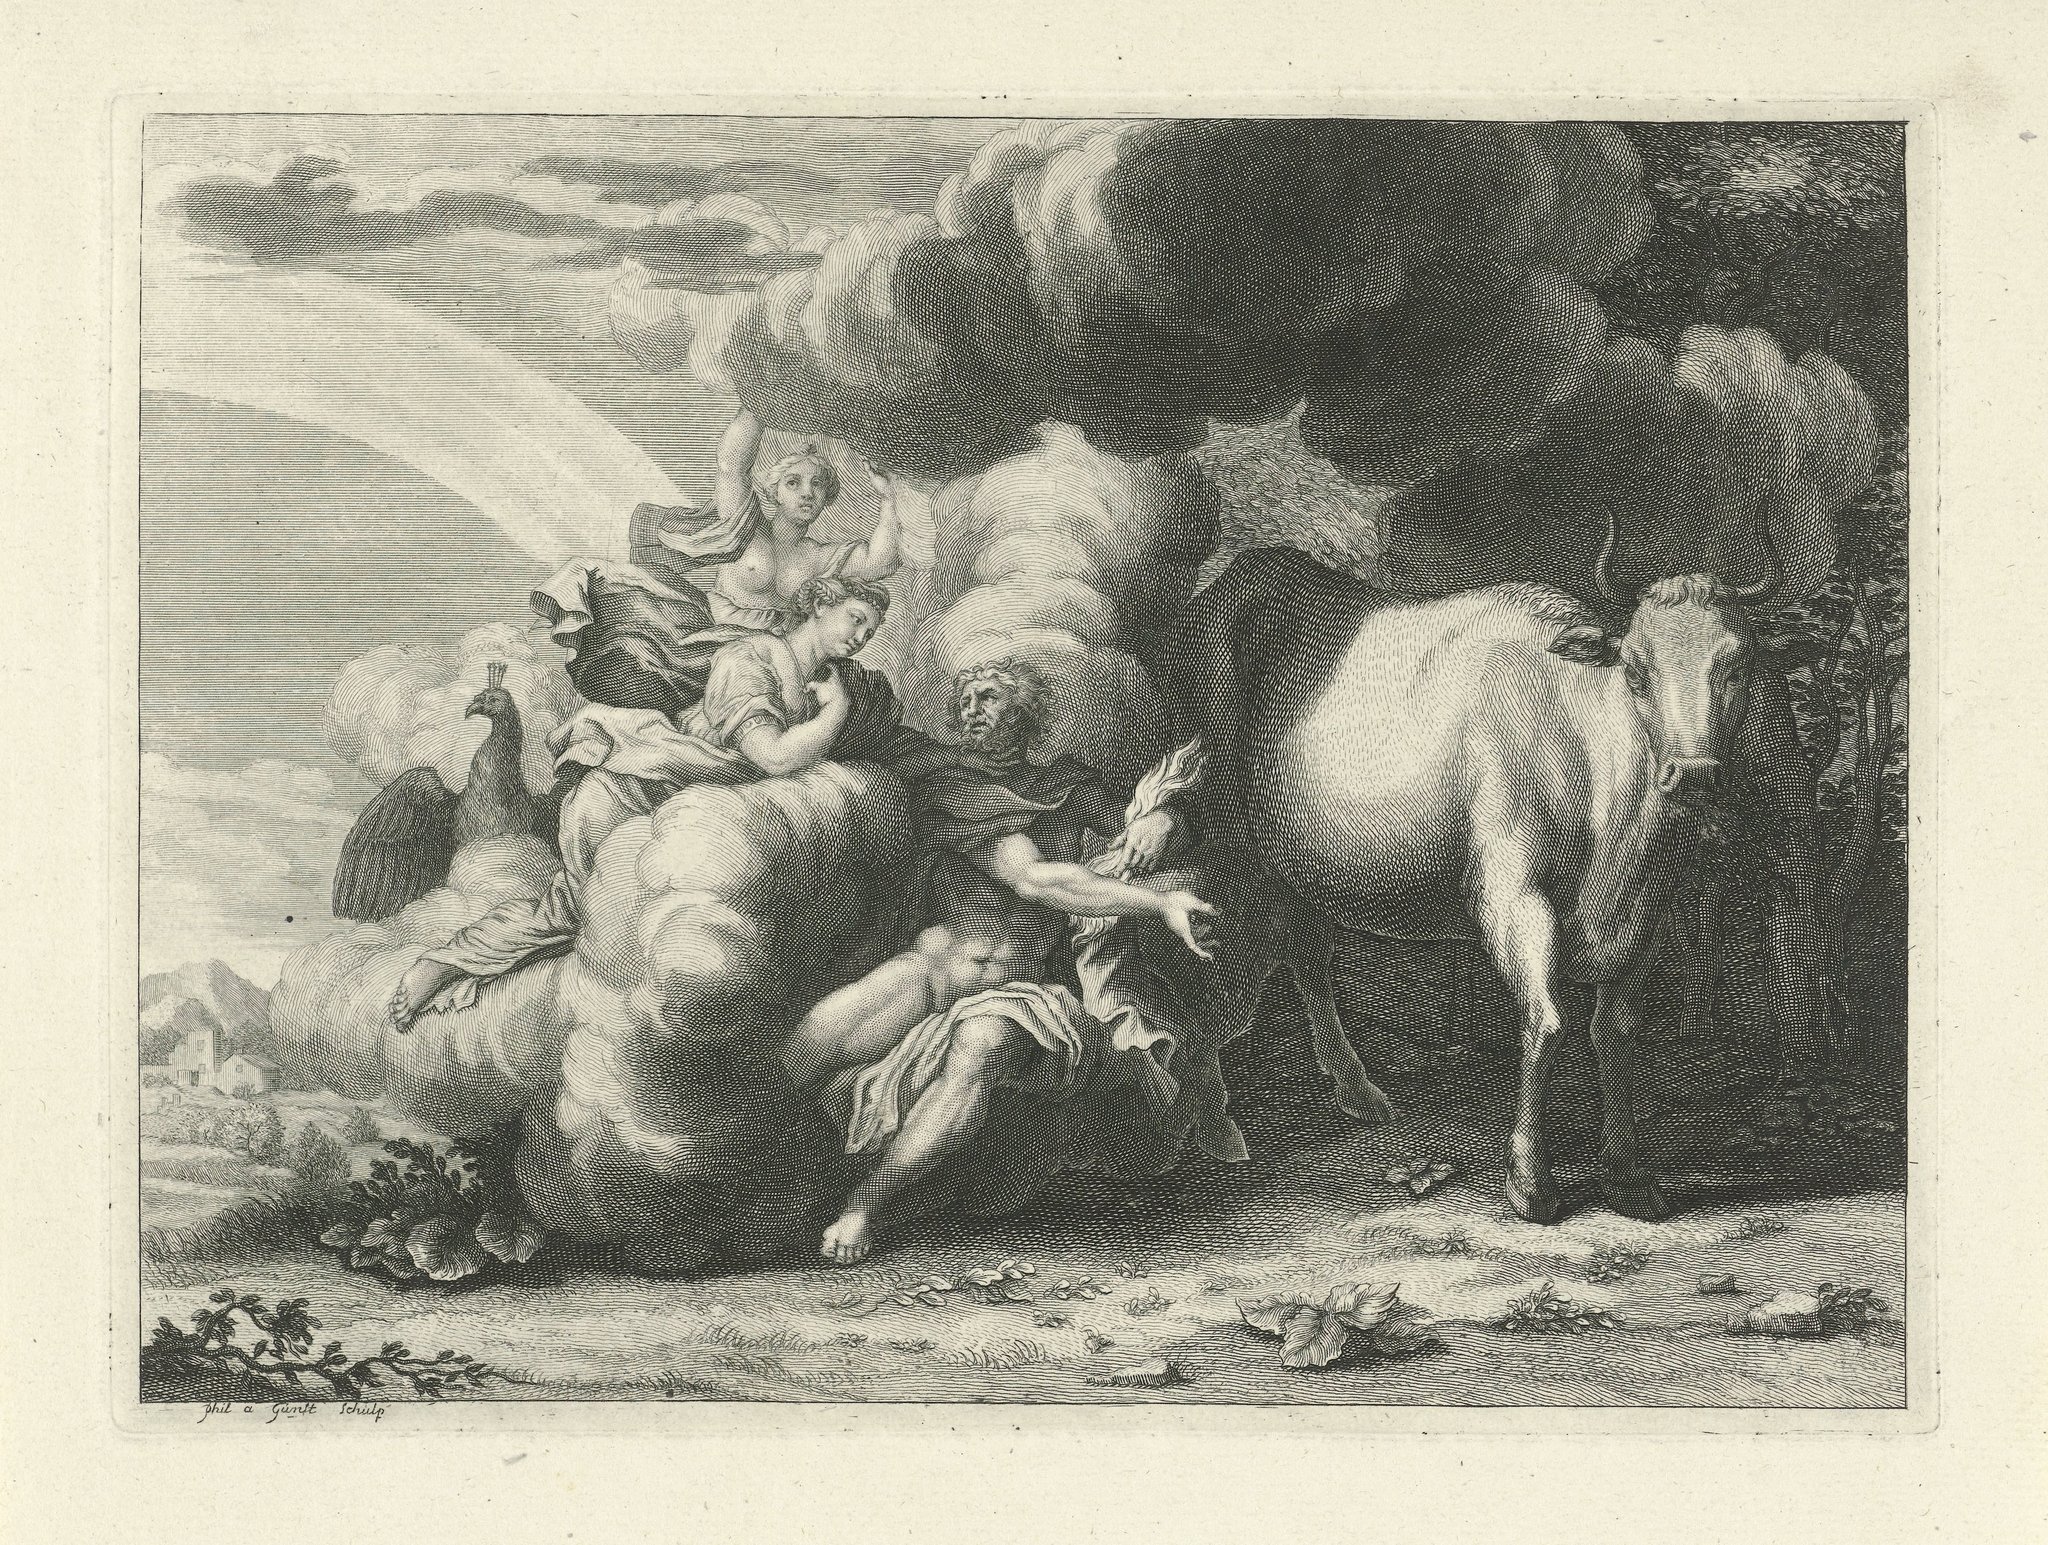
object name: print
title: Jupiter geeft de koe Io als geschenk aan Juno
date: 1685-1732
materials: paper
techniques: engraving, etching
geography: amsterdam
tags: io changed into a cow: to avoid detection by juno, jupiter changes io into a cow (ovid, metamorphoses i 611)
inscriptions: collector's mark: Lugt 2228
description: Jupiter heeft Io, zijn geliefde, in een witte koe veranderd om haar voor zijn vrouw Juno te verbergen. Juno vraagt de koe als geschenk.